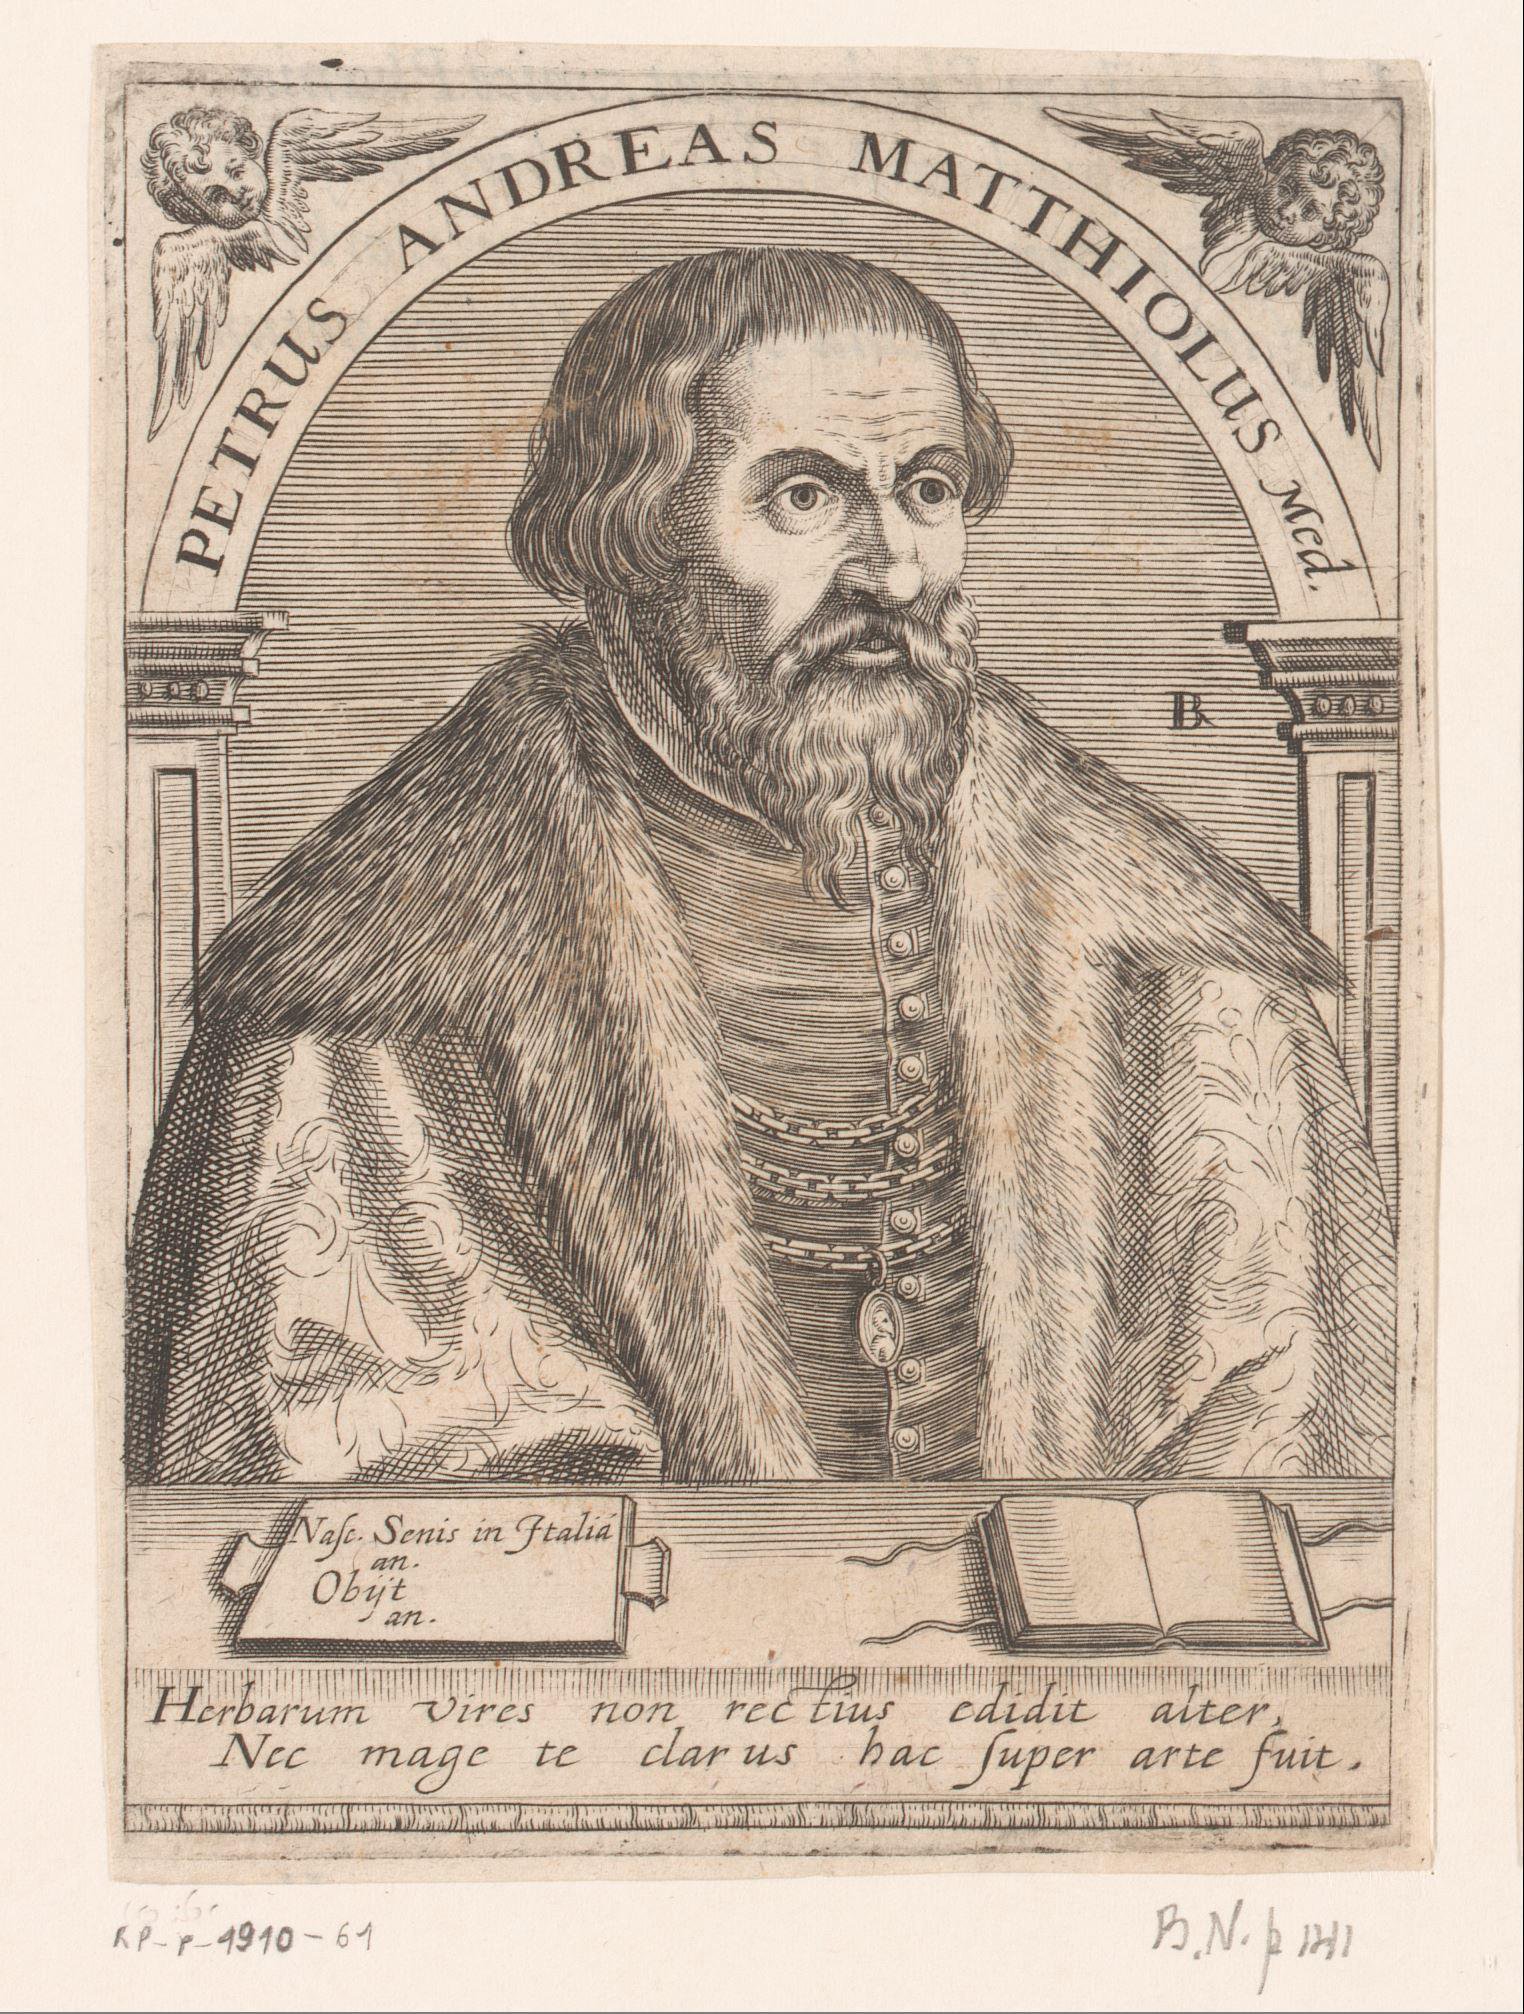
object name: book illustration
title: Serie portretten van vijftiende- en zestiende-eeuwse geleerden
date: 1597-1599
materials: paper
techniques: engraving, letterpress printing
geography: france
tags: historical persons, book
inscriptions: collector's mark: Lugt 2228